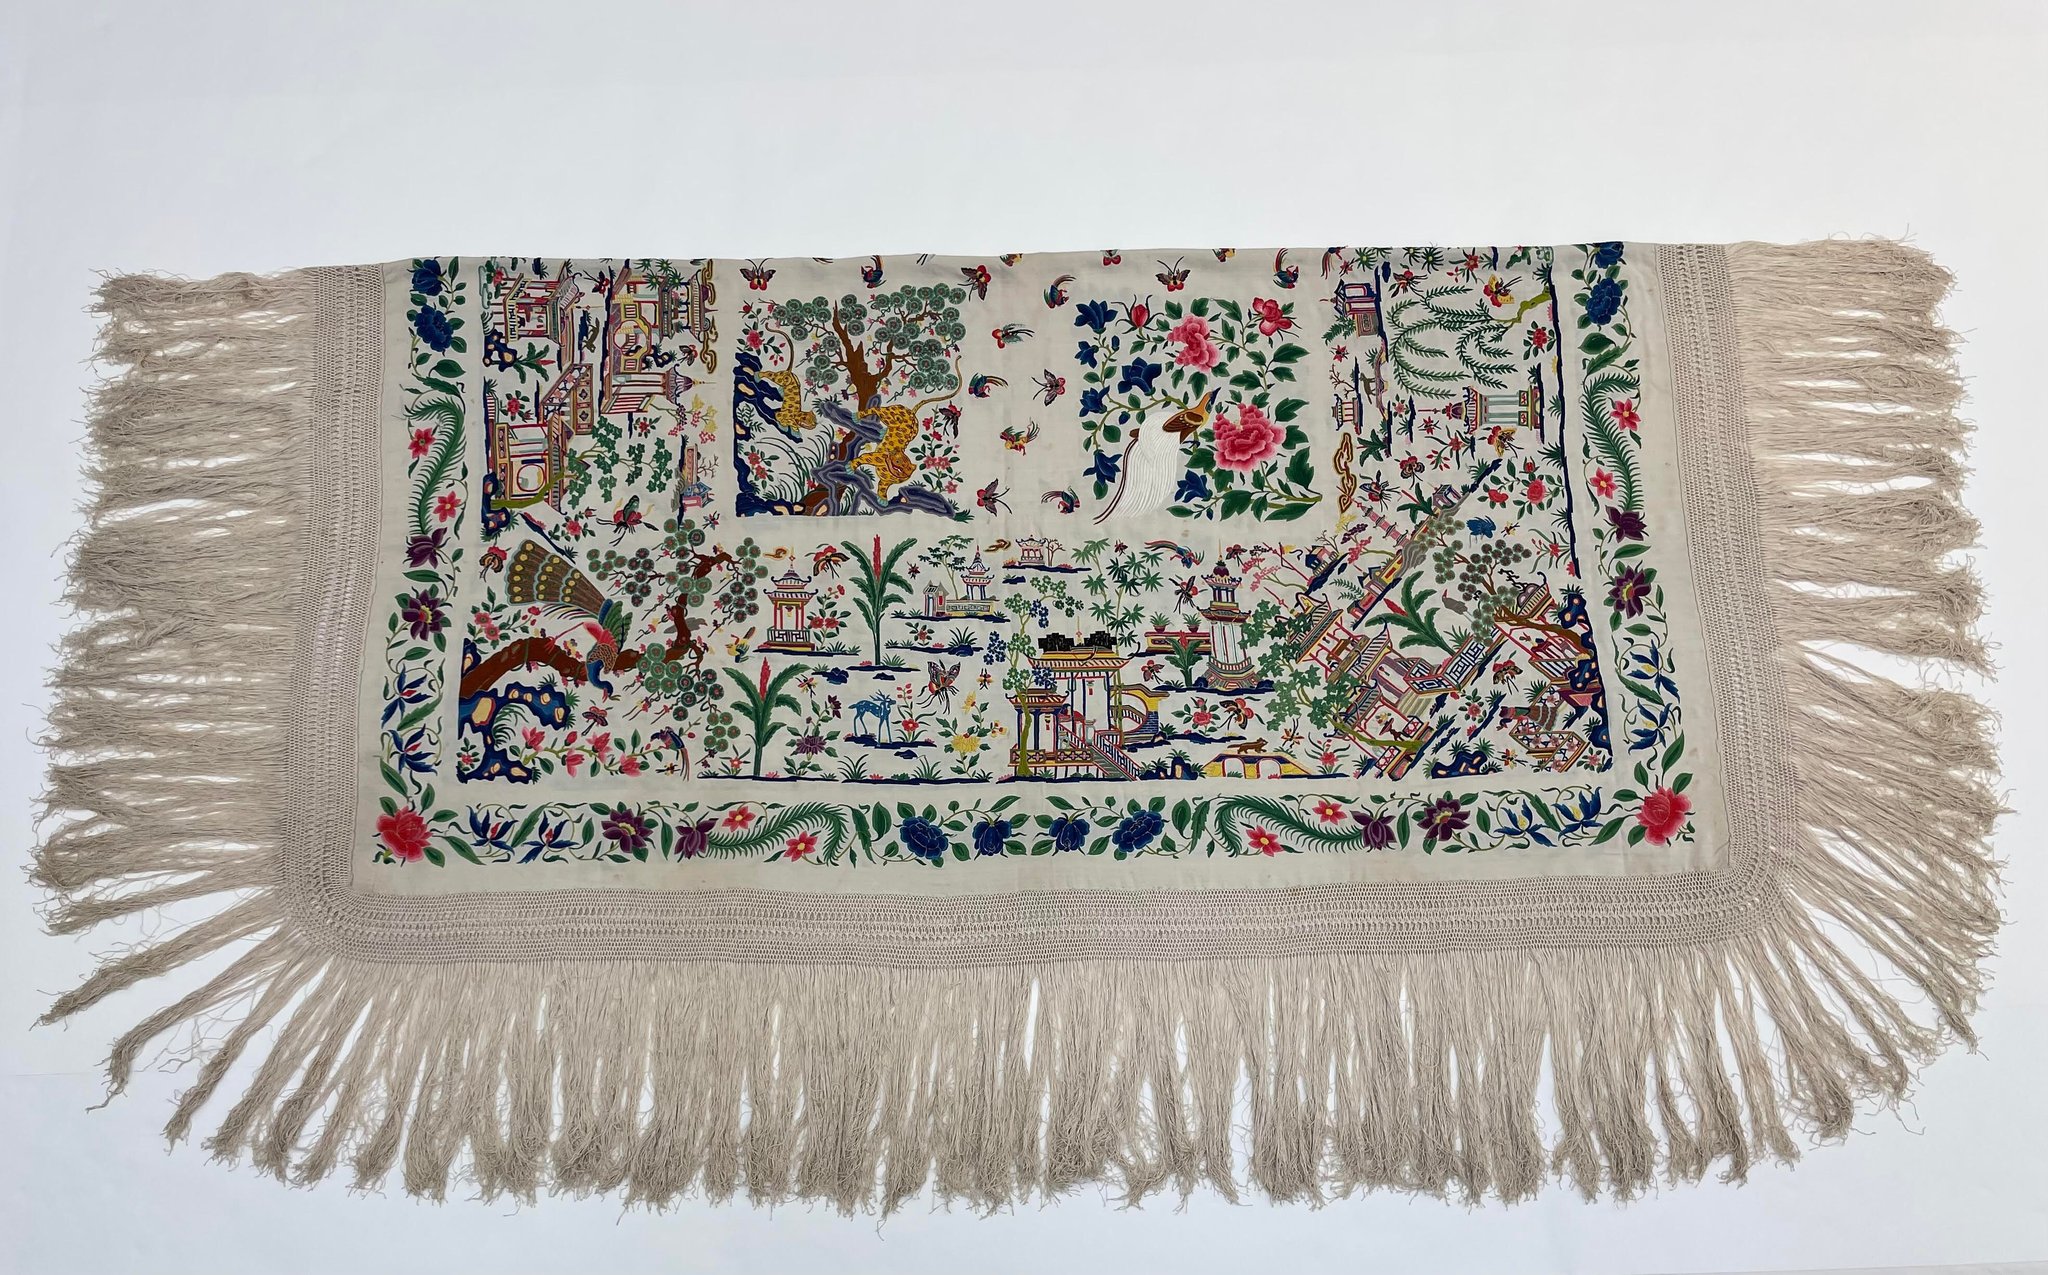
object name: shawl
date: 1801-1900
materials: silk